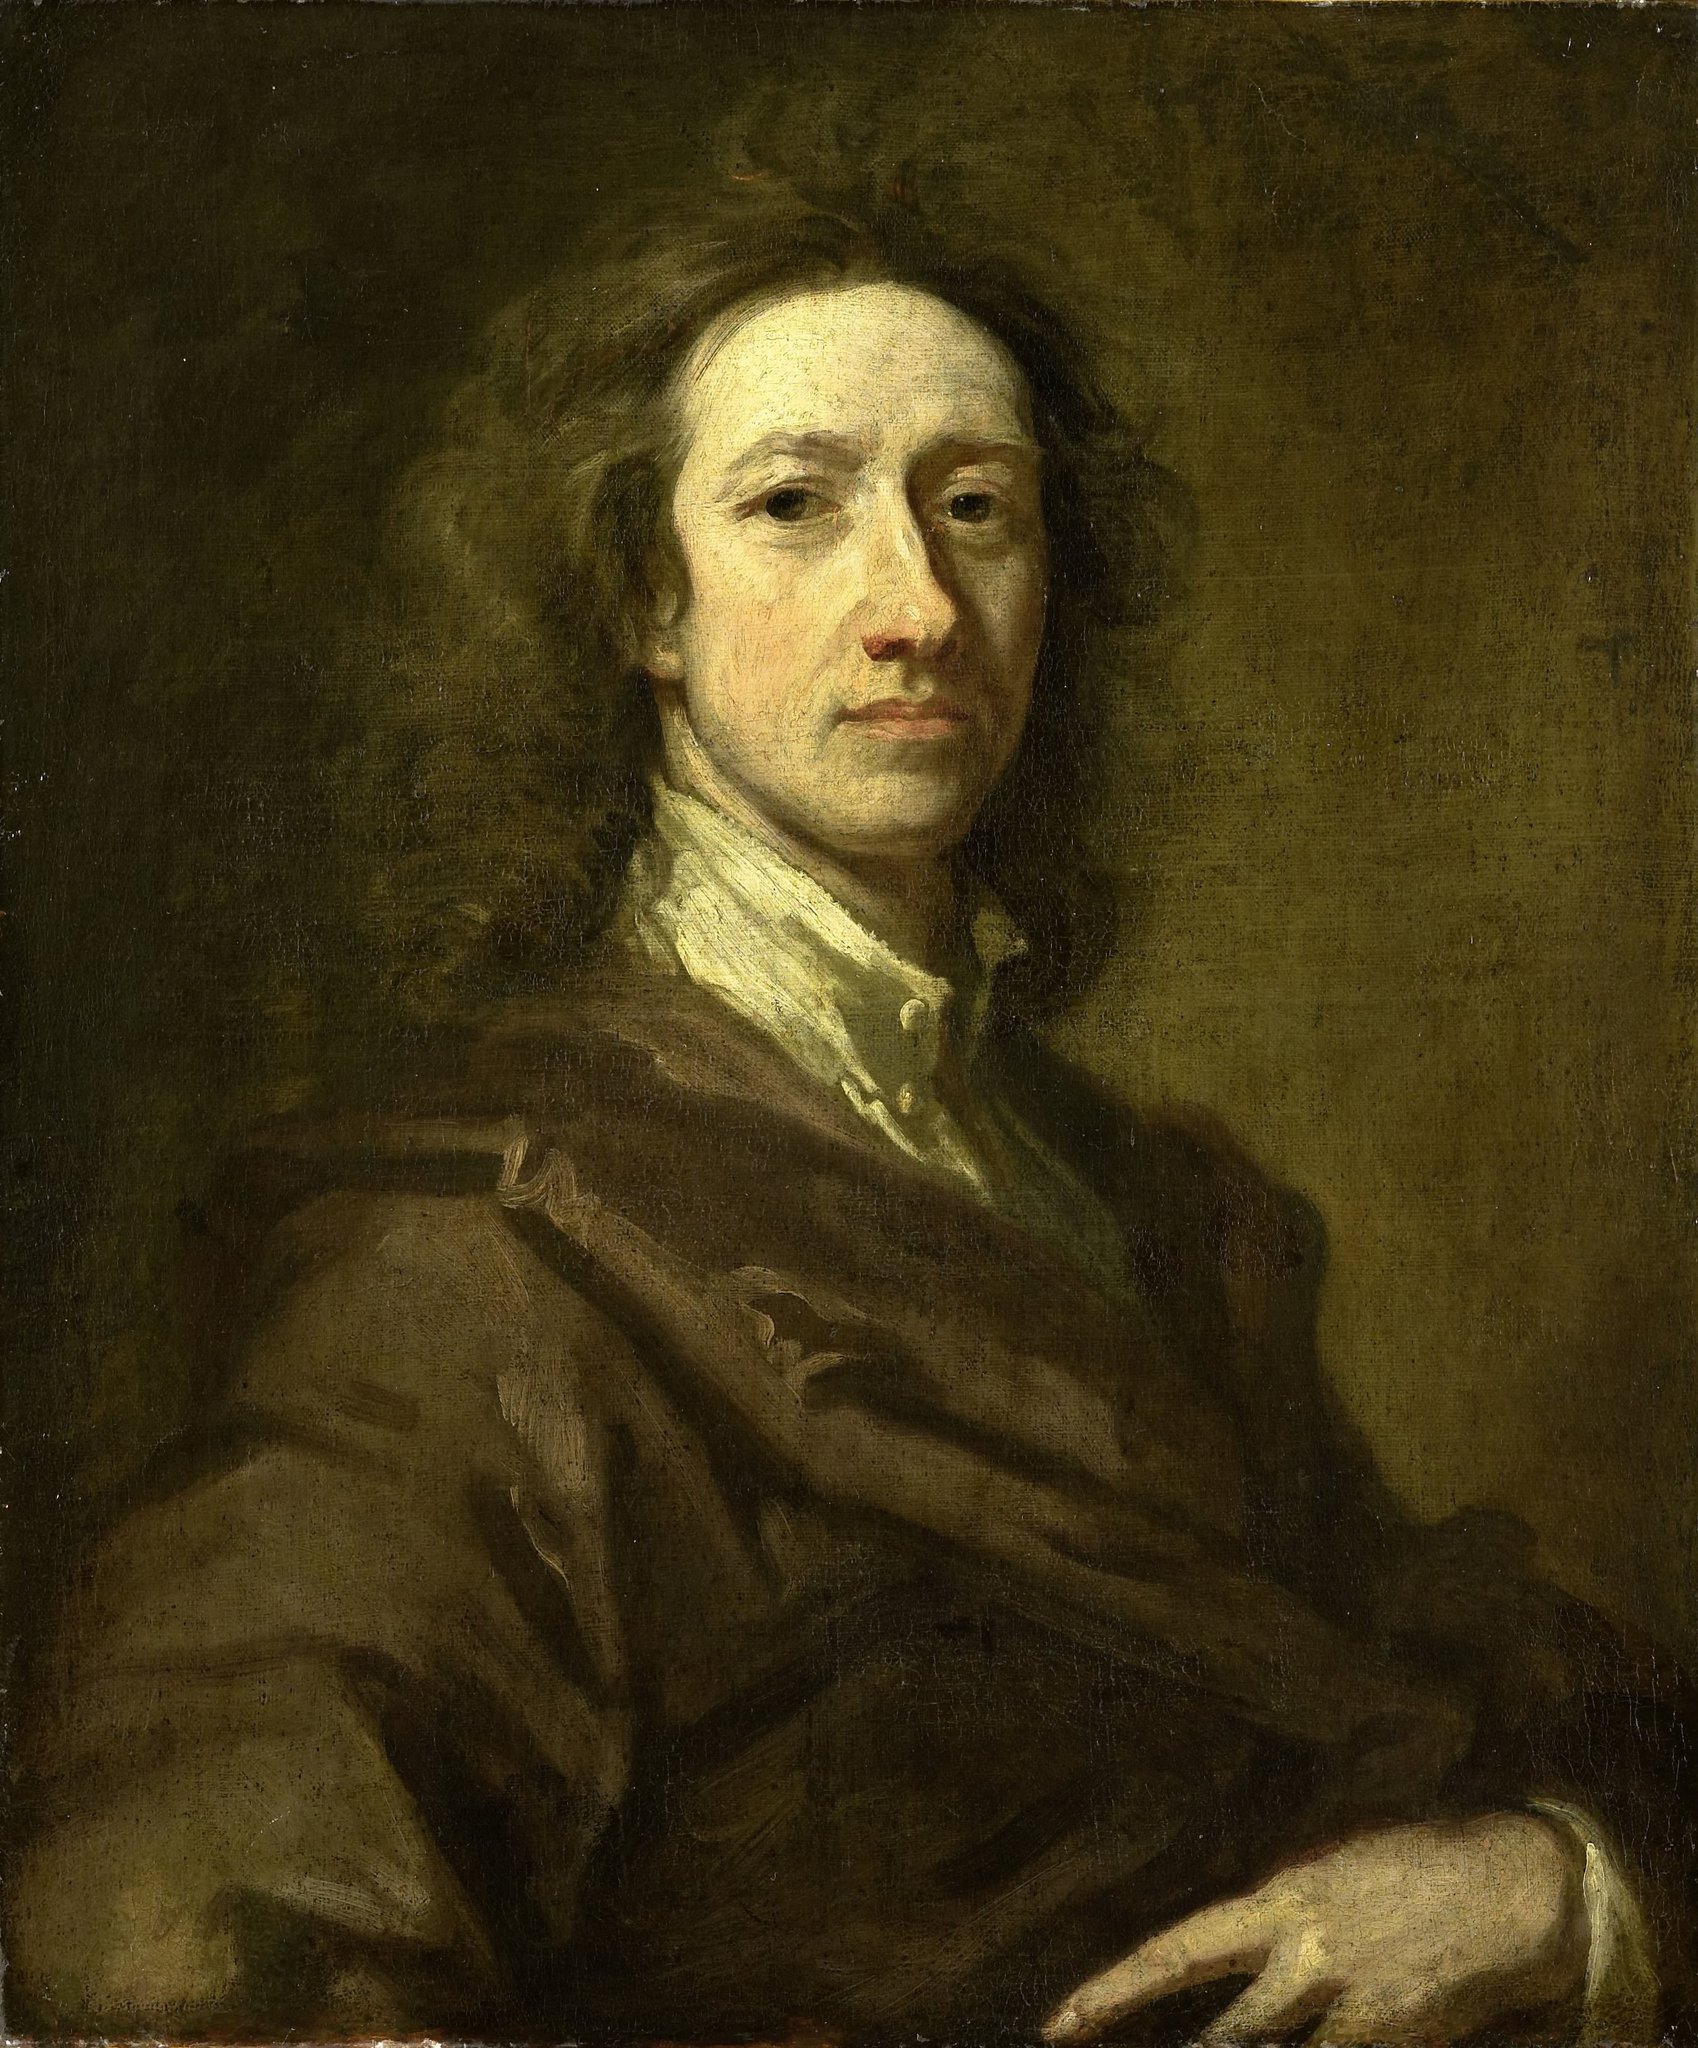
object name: painting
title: Cornelis de Bruyn (1652-1727), Draftsman and Traveller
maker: gottfried kneller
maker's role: draughtsman, painter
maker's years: 1646-1723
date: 1695-1700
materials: canvas, oil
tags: the hague, utrecht, cornelis de bruyn, historical persons, portrait, self-portrait of draughtsman, explorer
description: Sir Godfried Kneller (1646 - 1723). Cornelis de Bruyn (1652 - 1727). Artist and traveller.